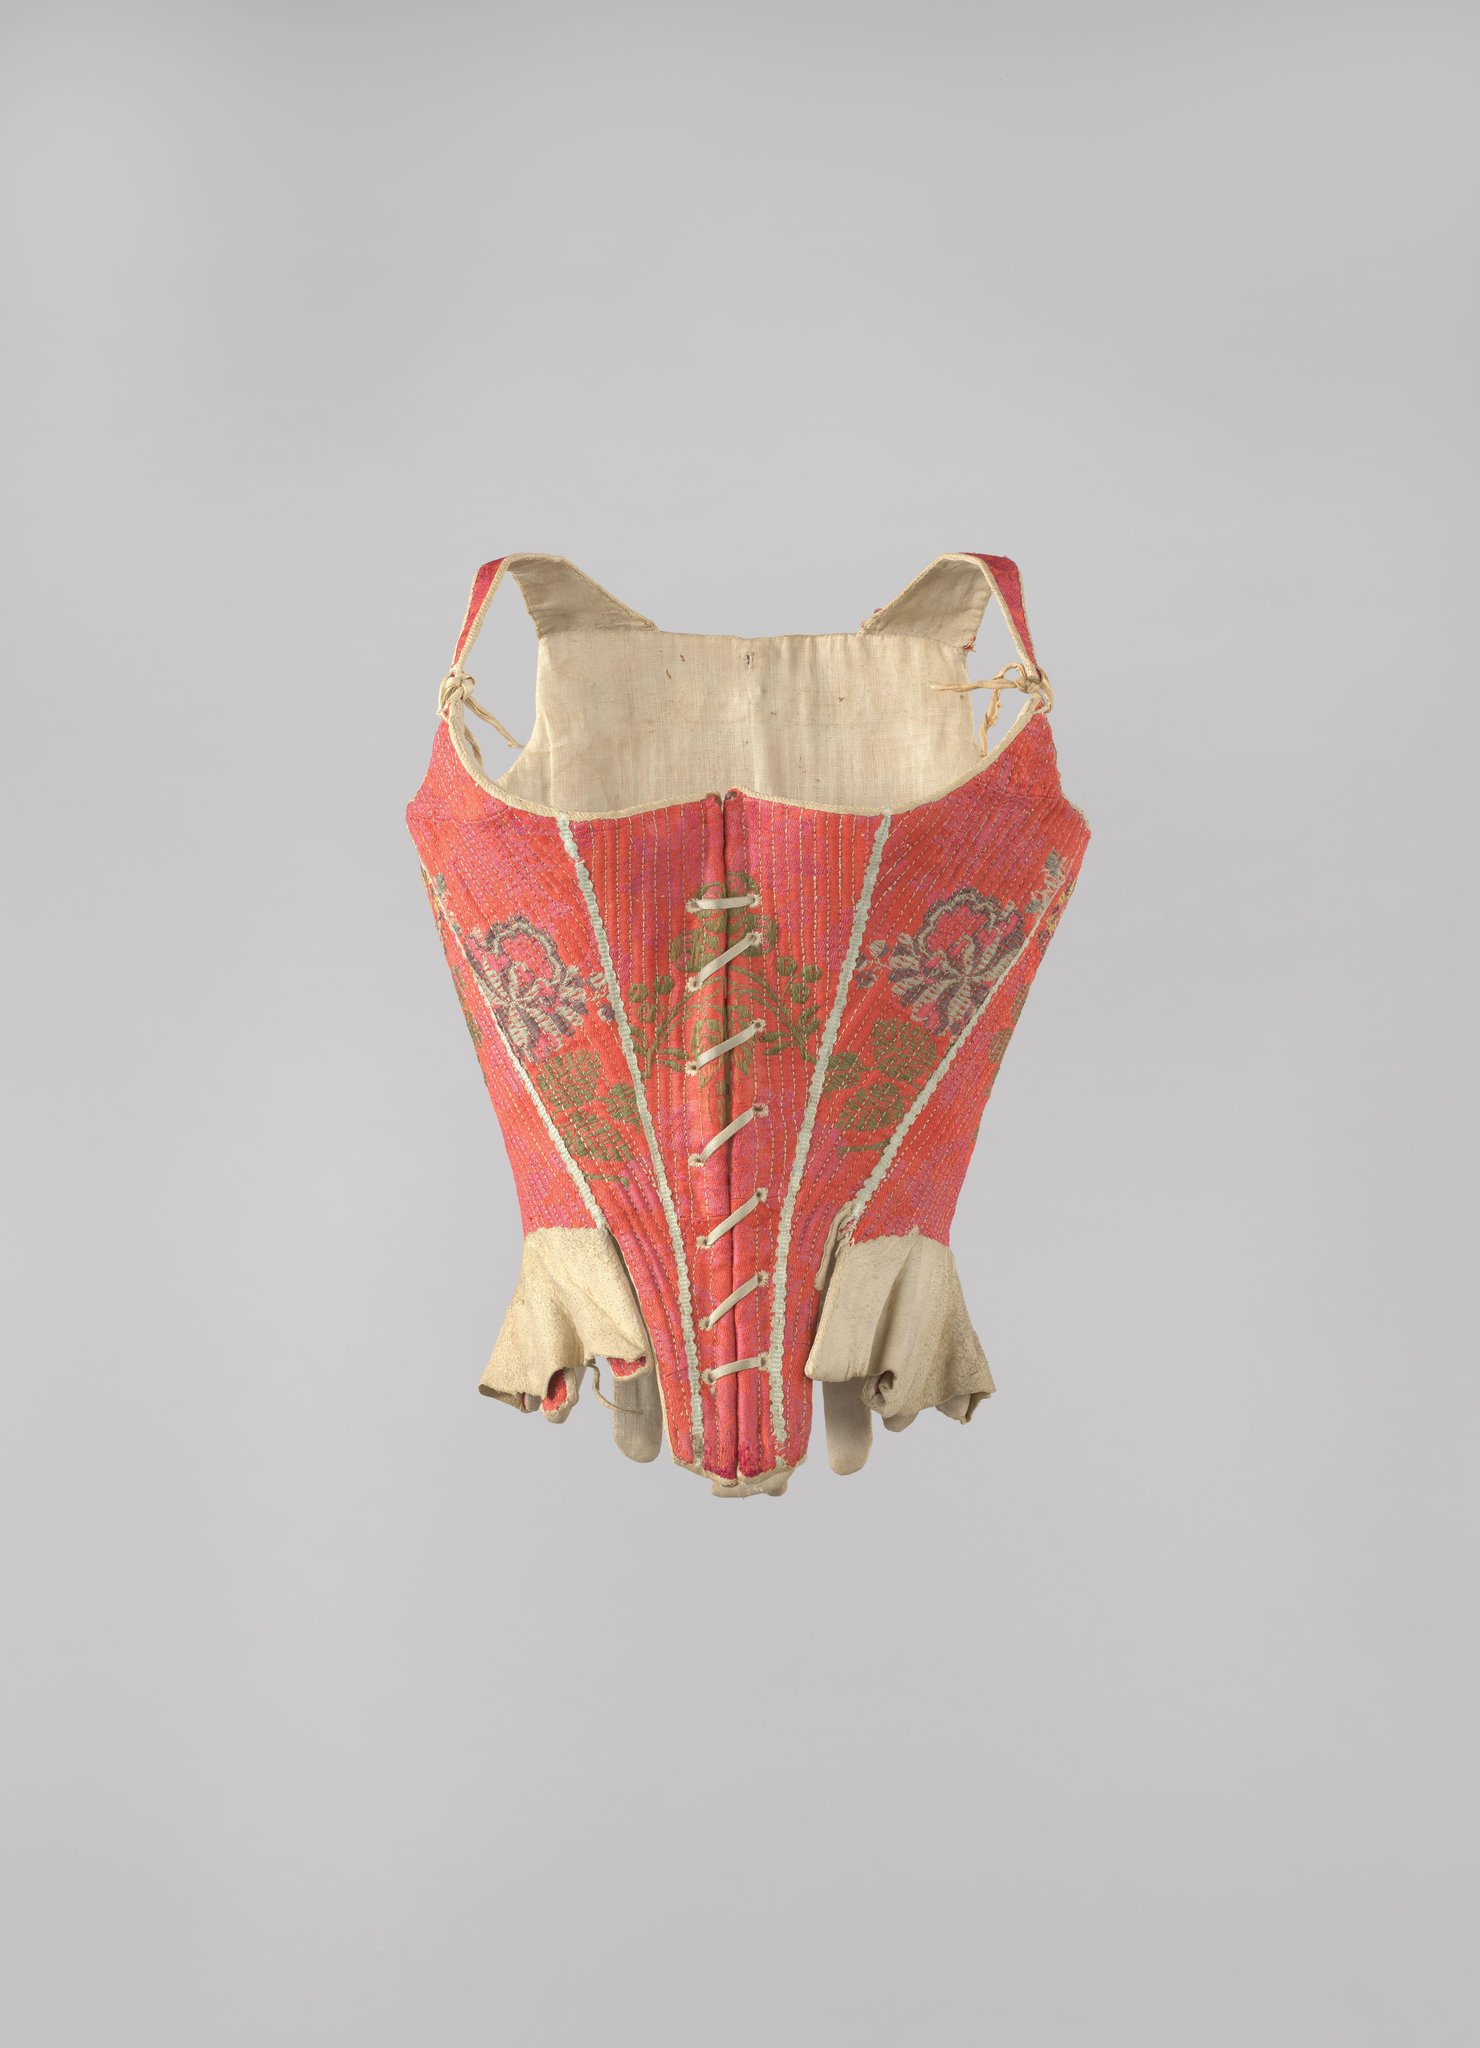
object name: womenswear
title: Corset overtrokken met een ceriserood wollen weefsel, versierd met polychrome bloemen en wit passement langs vijf rugnaden en vier voornaden.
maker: Anonymous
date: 1740-1760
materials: leather, wood, wool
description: Corset overtrokken met een ceriserood wollen weefsel, versierd met polychrome bloemen en wit passement langs vijf rugnaden en vier voornaden. Houten baleinen zijn over de gehele hoogte ingestikt. Middenvoor rijggaten en een spitse sneb, achter zes pattes. Zeemleren verlengstukjes in de zijden.